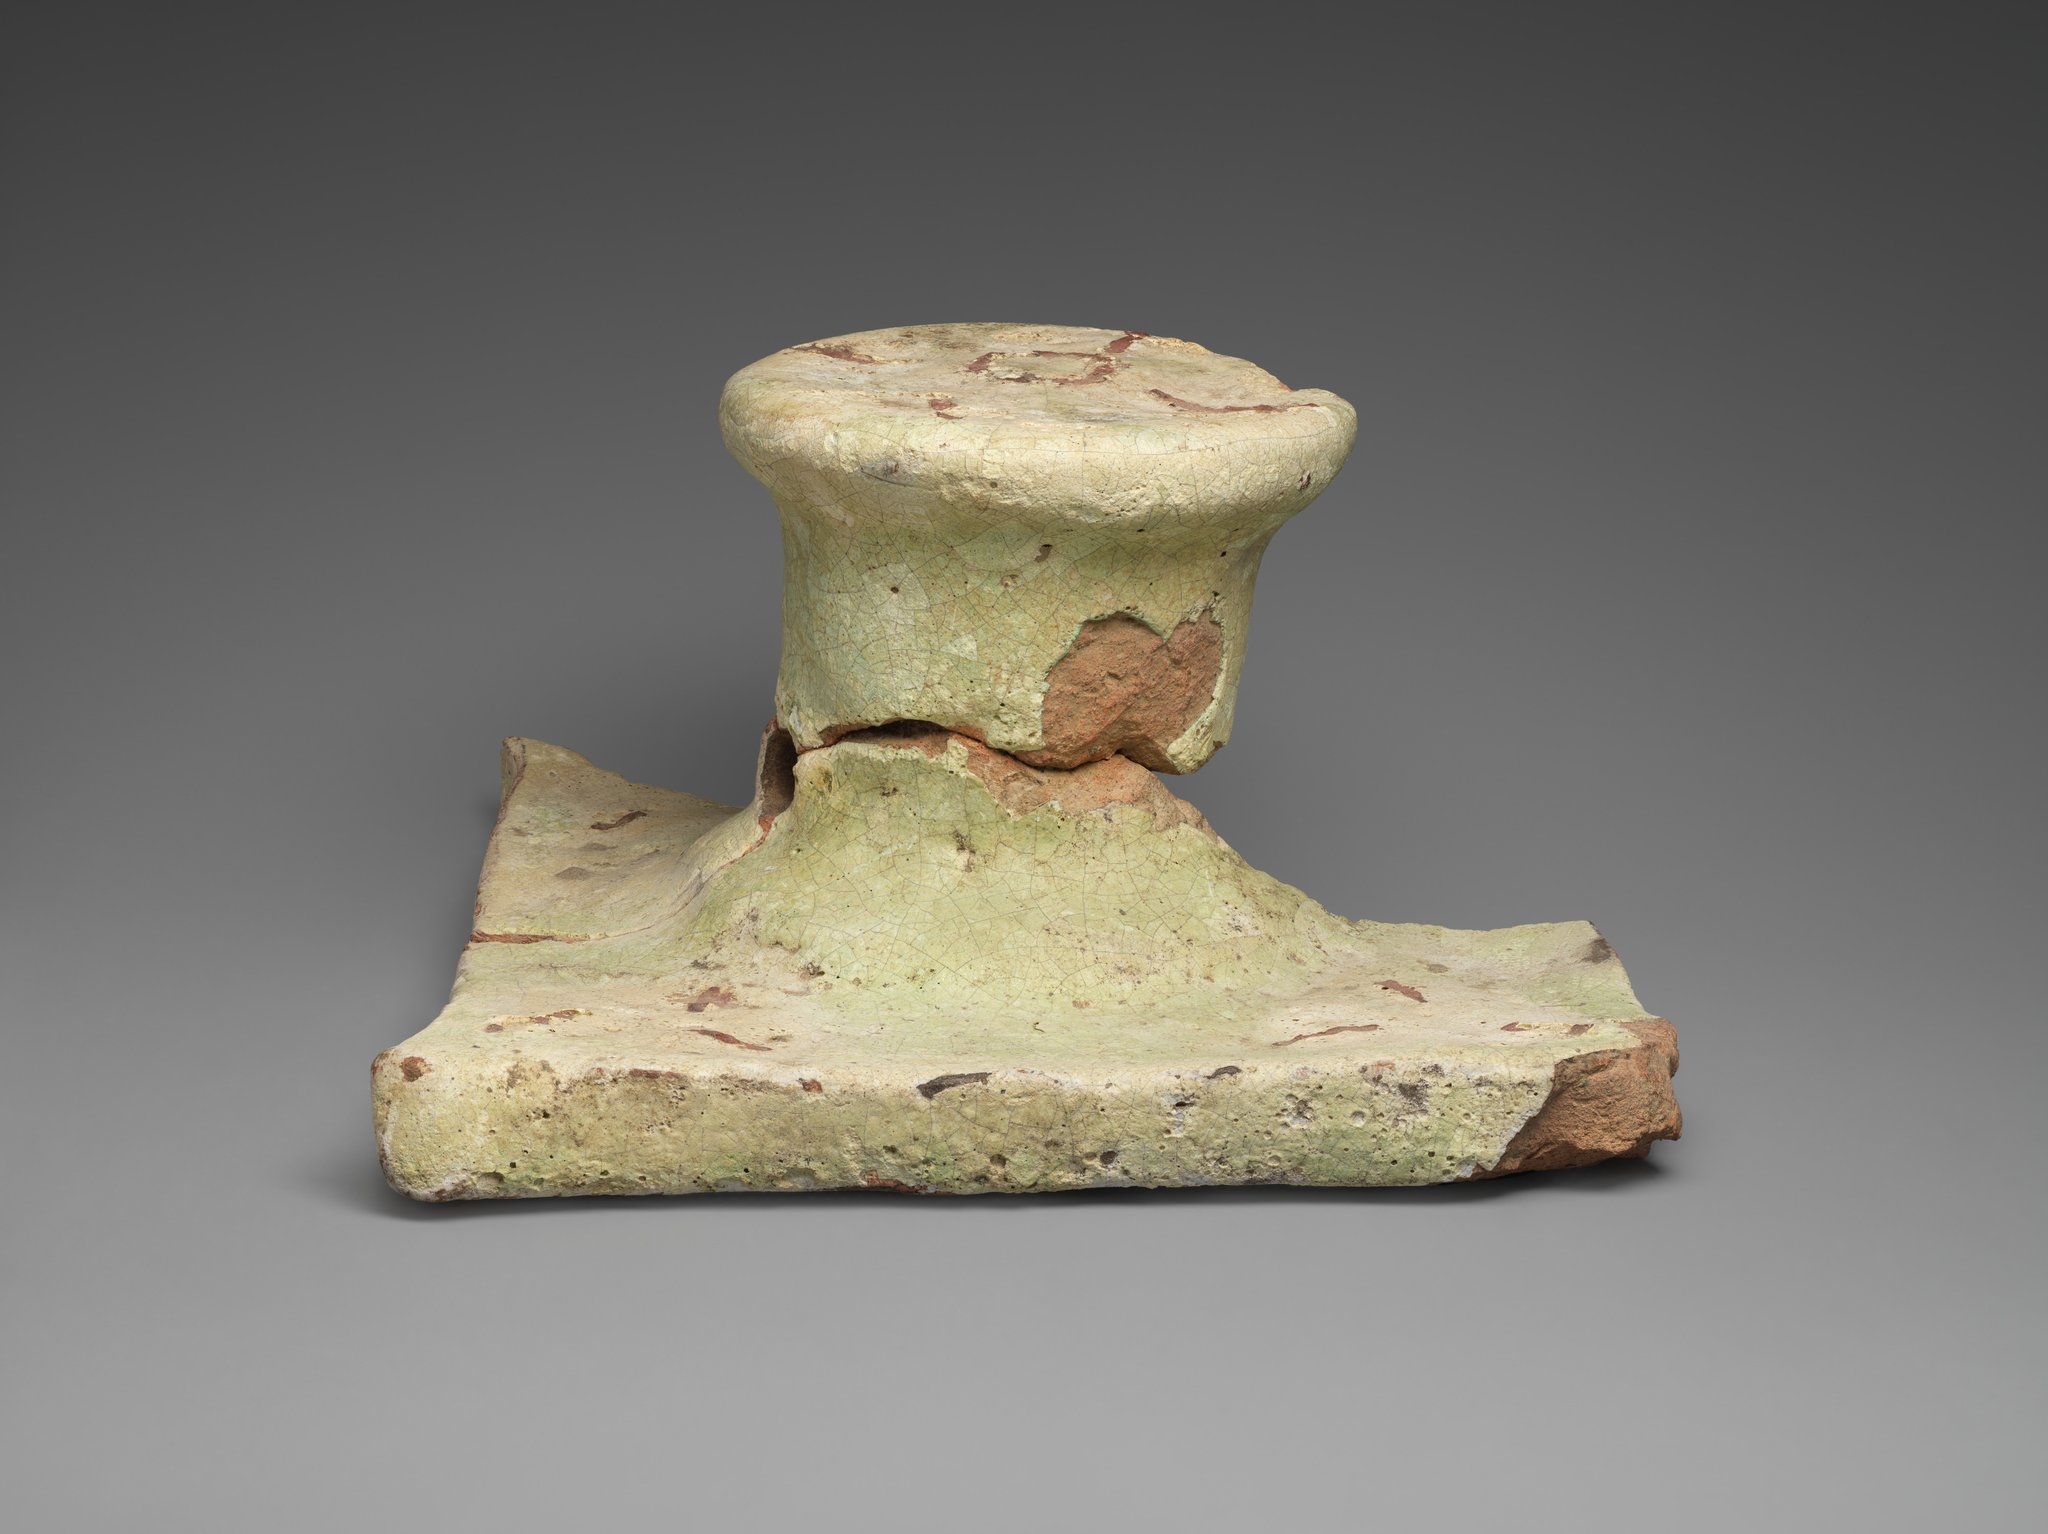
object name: wall plaque with knob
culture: iranian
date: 900-801 BCE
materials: ceramic, glaze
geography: iran